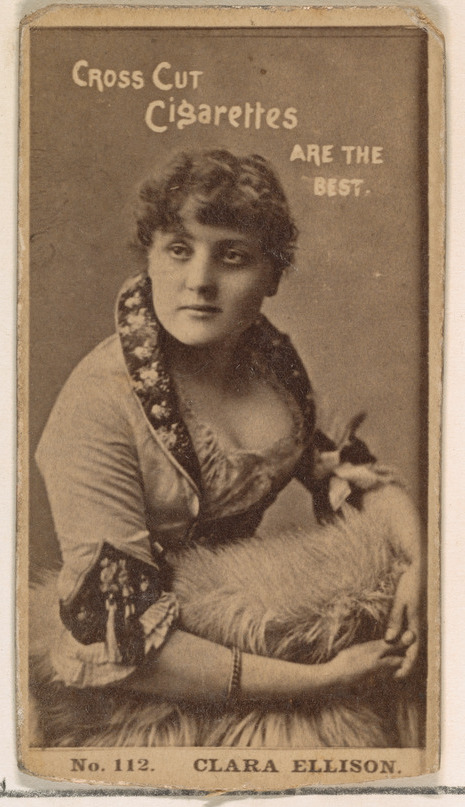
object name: print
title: Card Number 112, Clara Ellison, from the Actors and Actresses series (N145-2) issued by Duke Sons & Co. to promote Cross Cut Cigarettes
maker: w. duke, sons & co.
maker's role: publisher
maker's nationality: american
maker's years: 1870-1920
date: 1880-1889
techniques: albumen silver print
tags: portraits,women,actresses